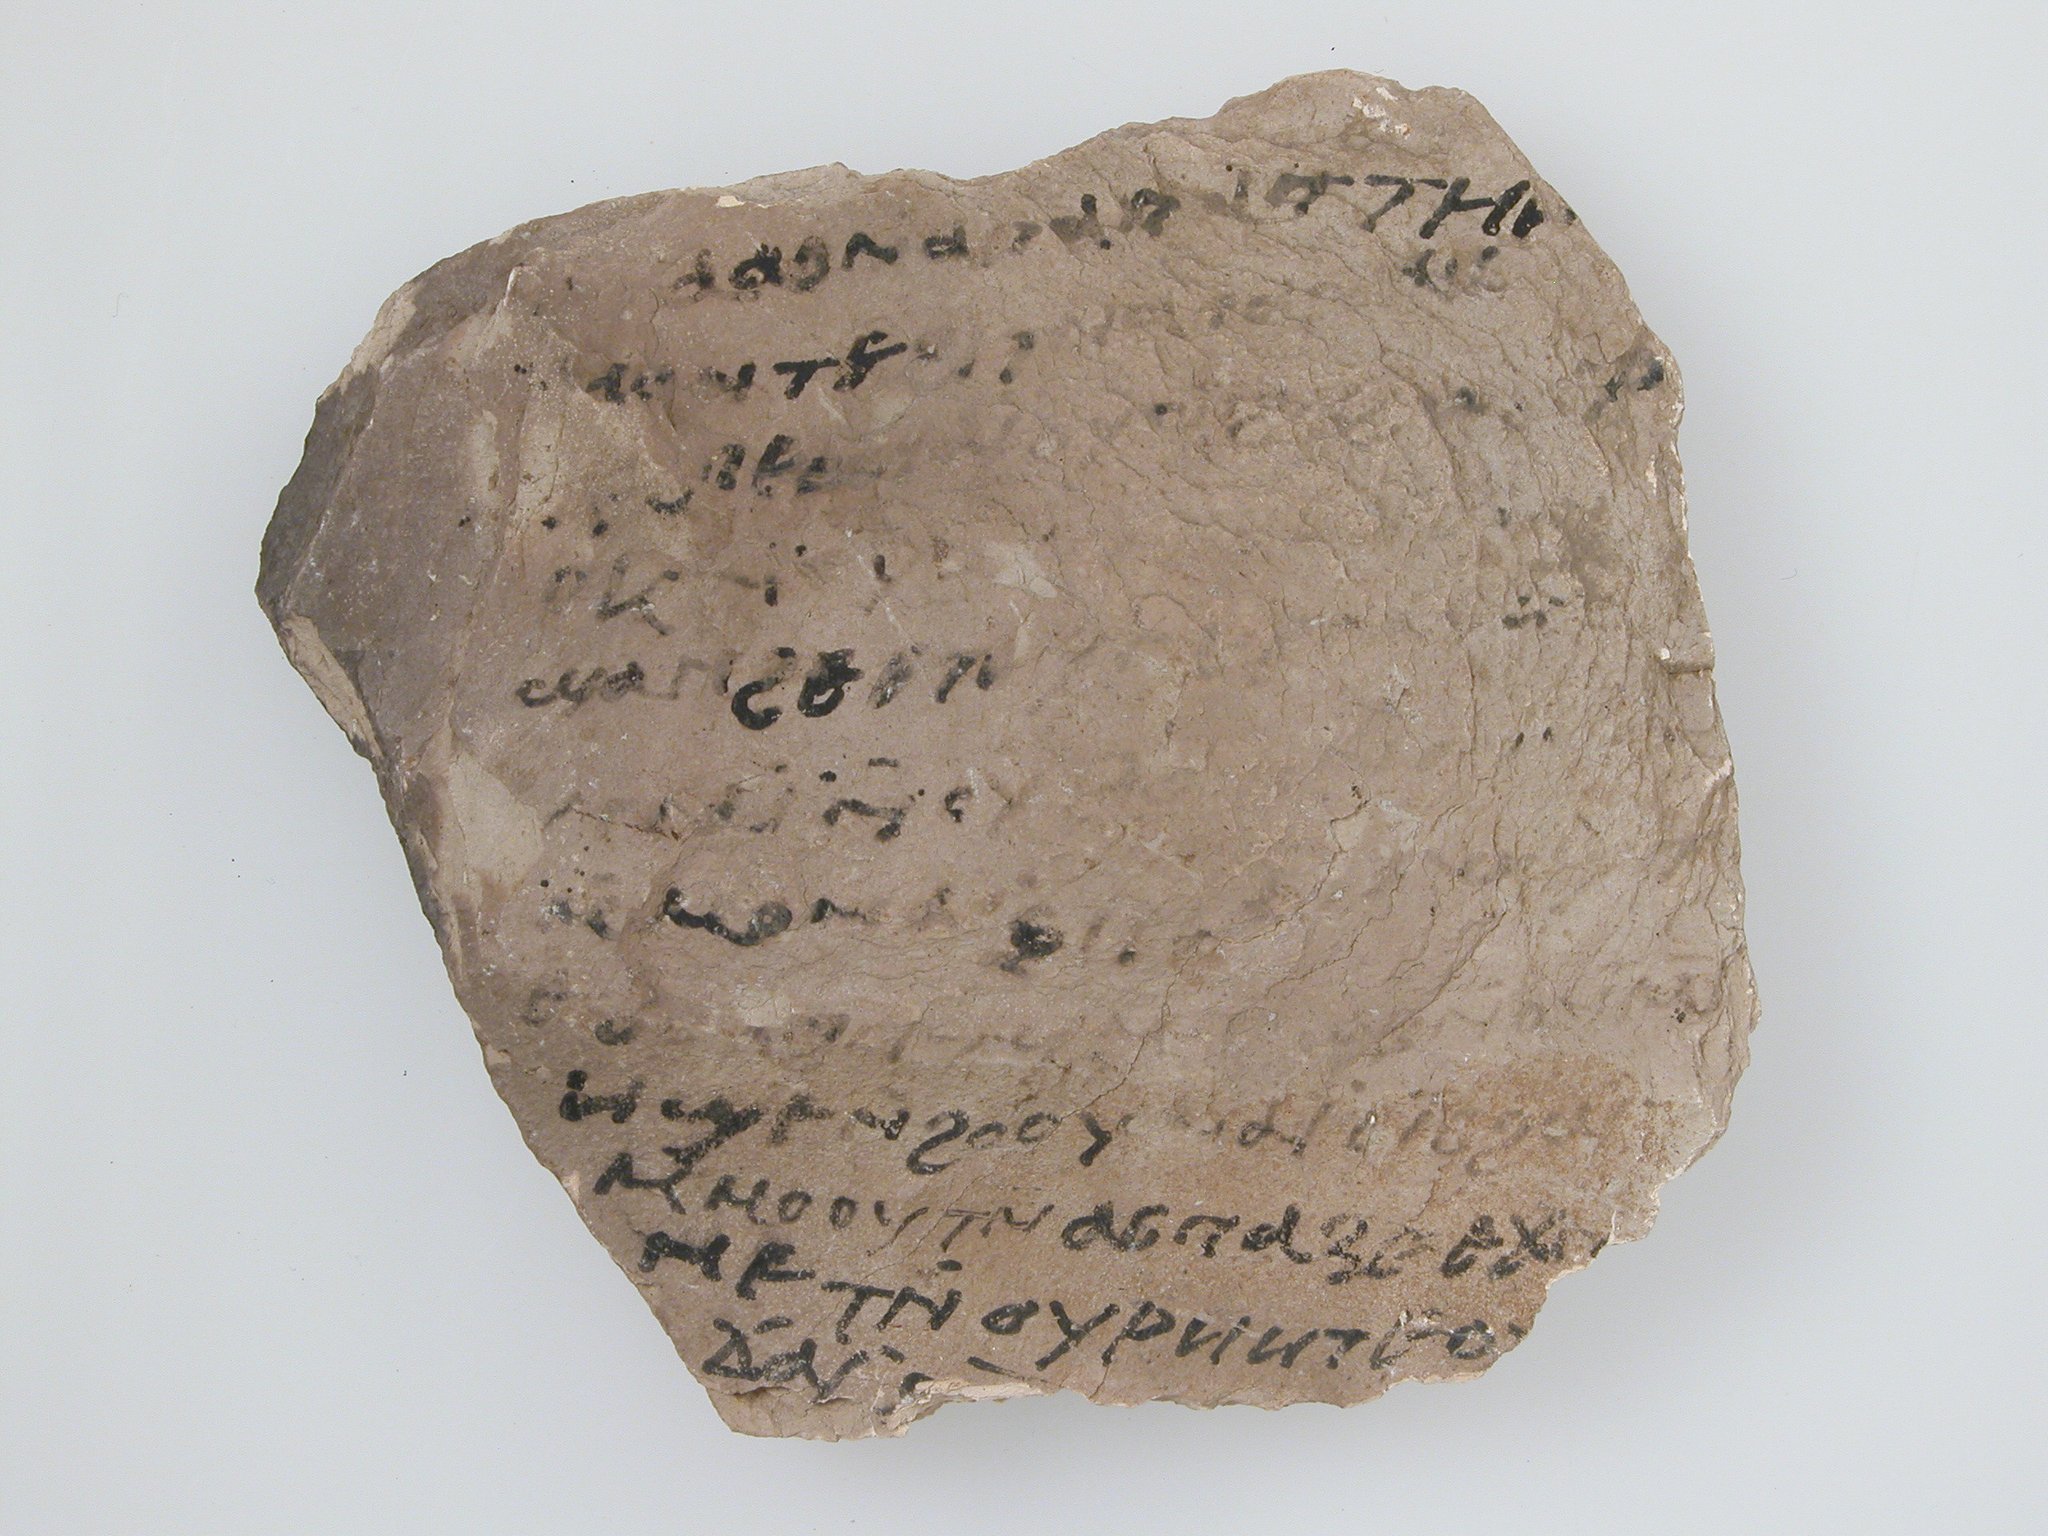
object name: ostrakon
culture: coptic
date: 600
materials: ink, pottery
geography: egypt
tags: coptic,documents